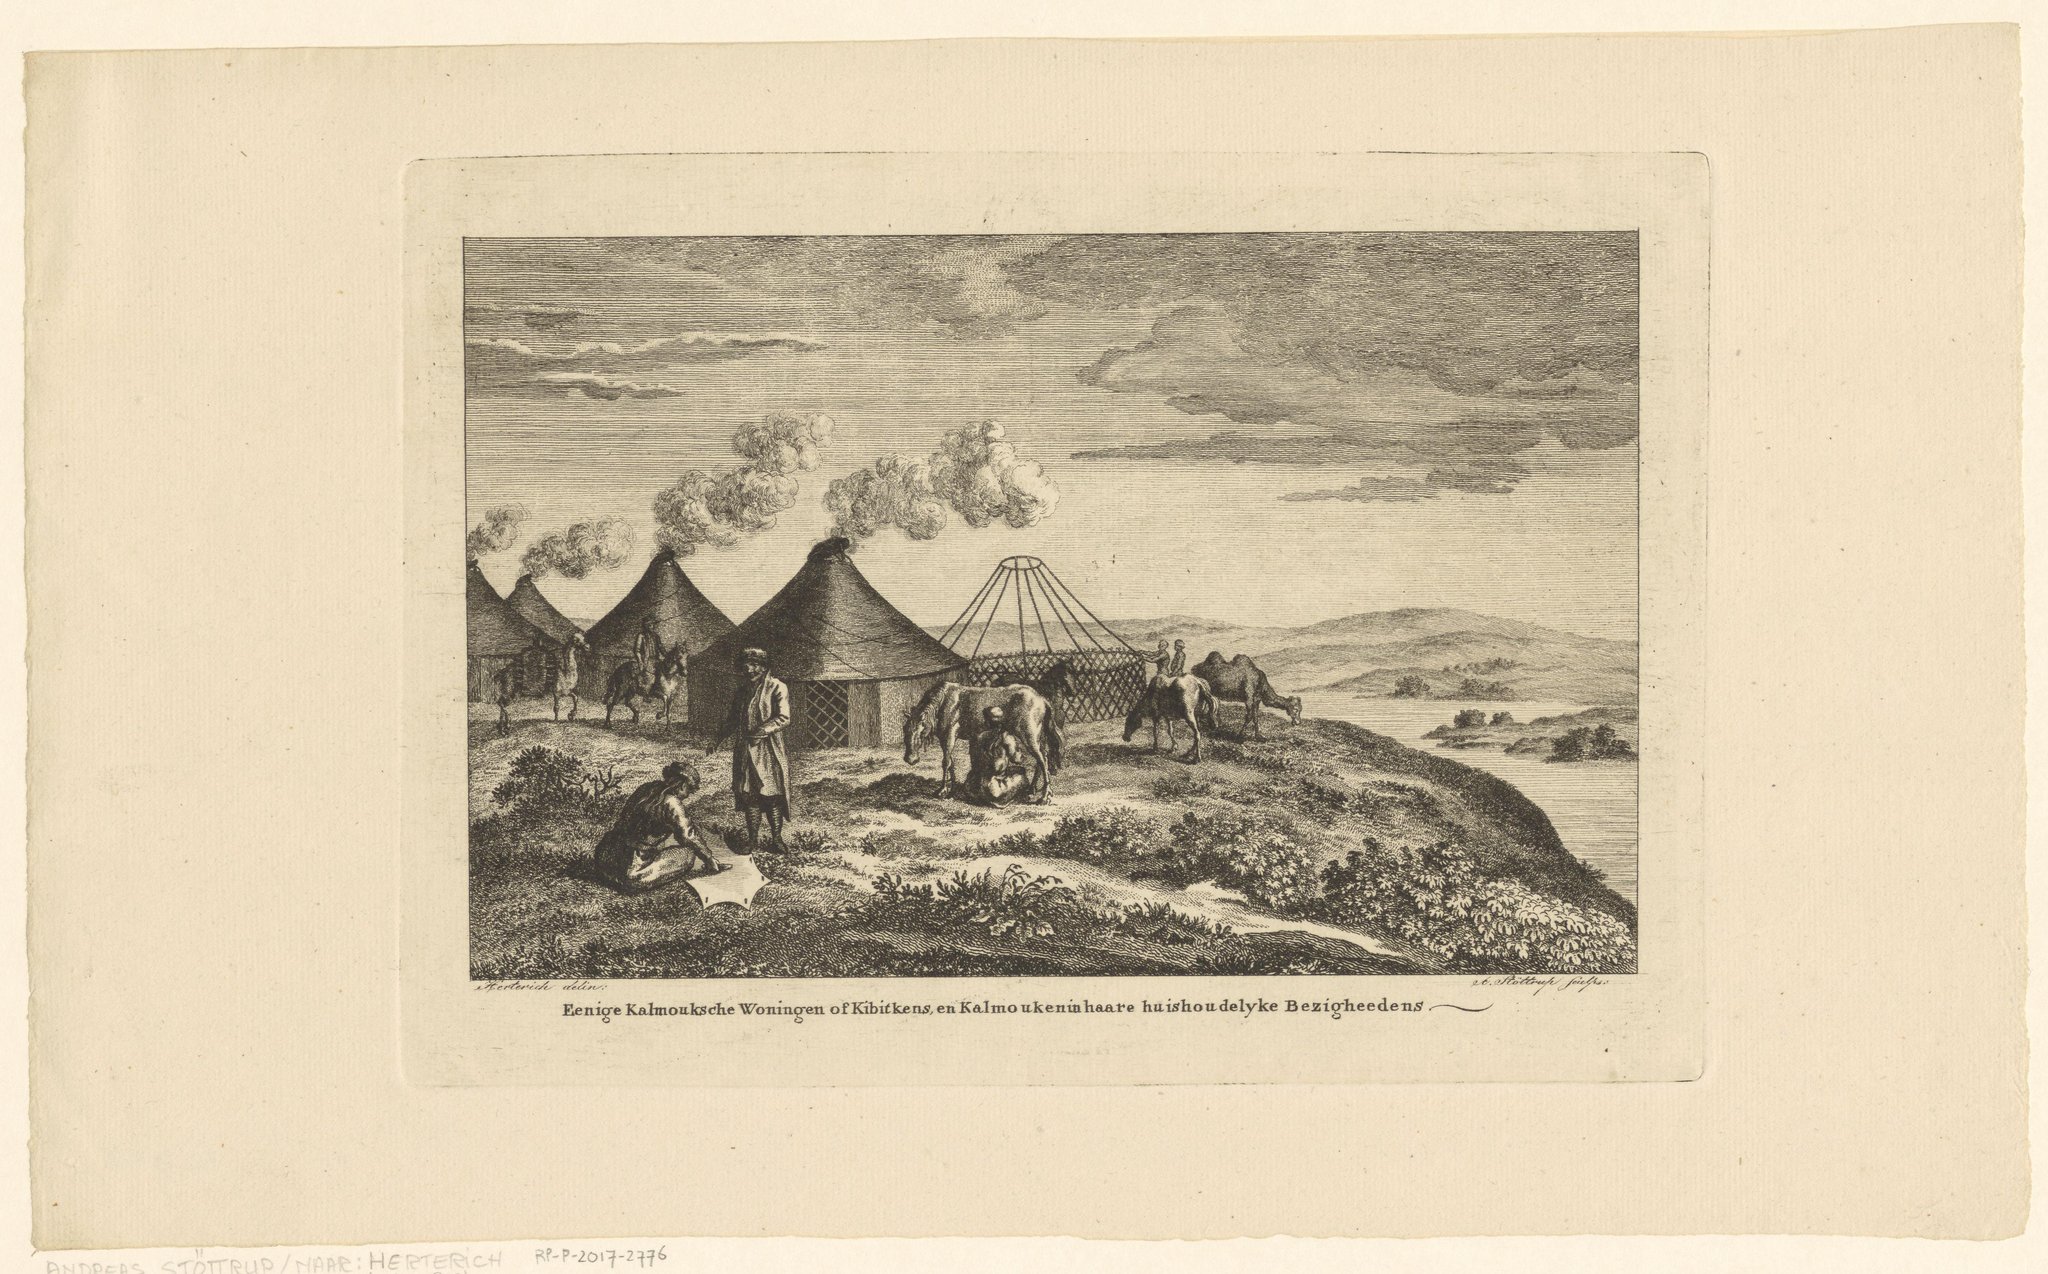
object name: print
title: Landschap met woningen van Kalmukken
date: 1782-1812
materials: paper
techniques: etching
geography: hamburg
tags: horse, civic architecture; edifices; dwellings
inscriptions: collector's mark: Lugt 2228